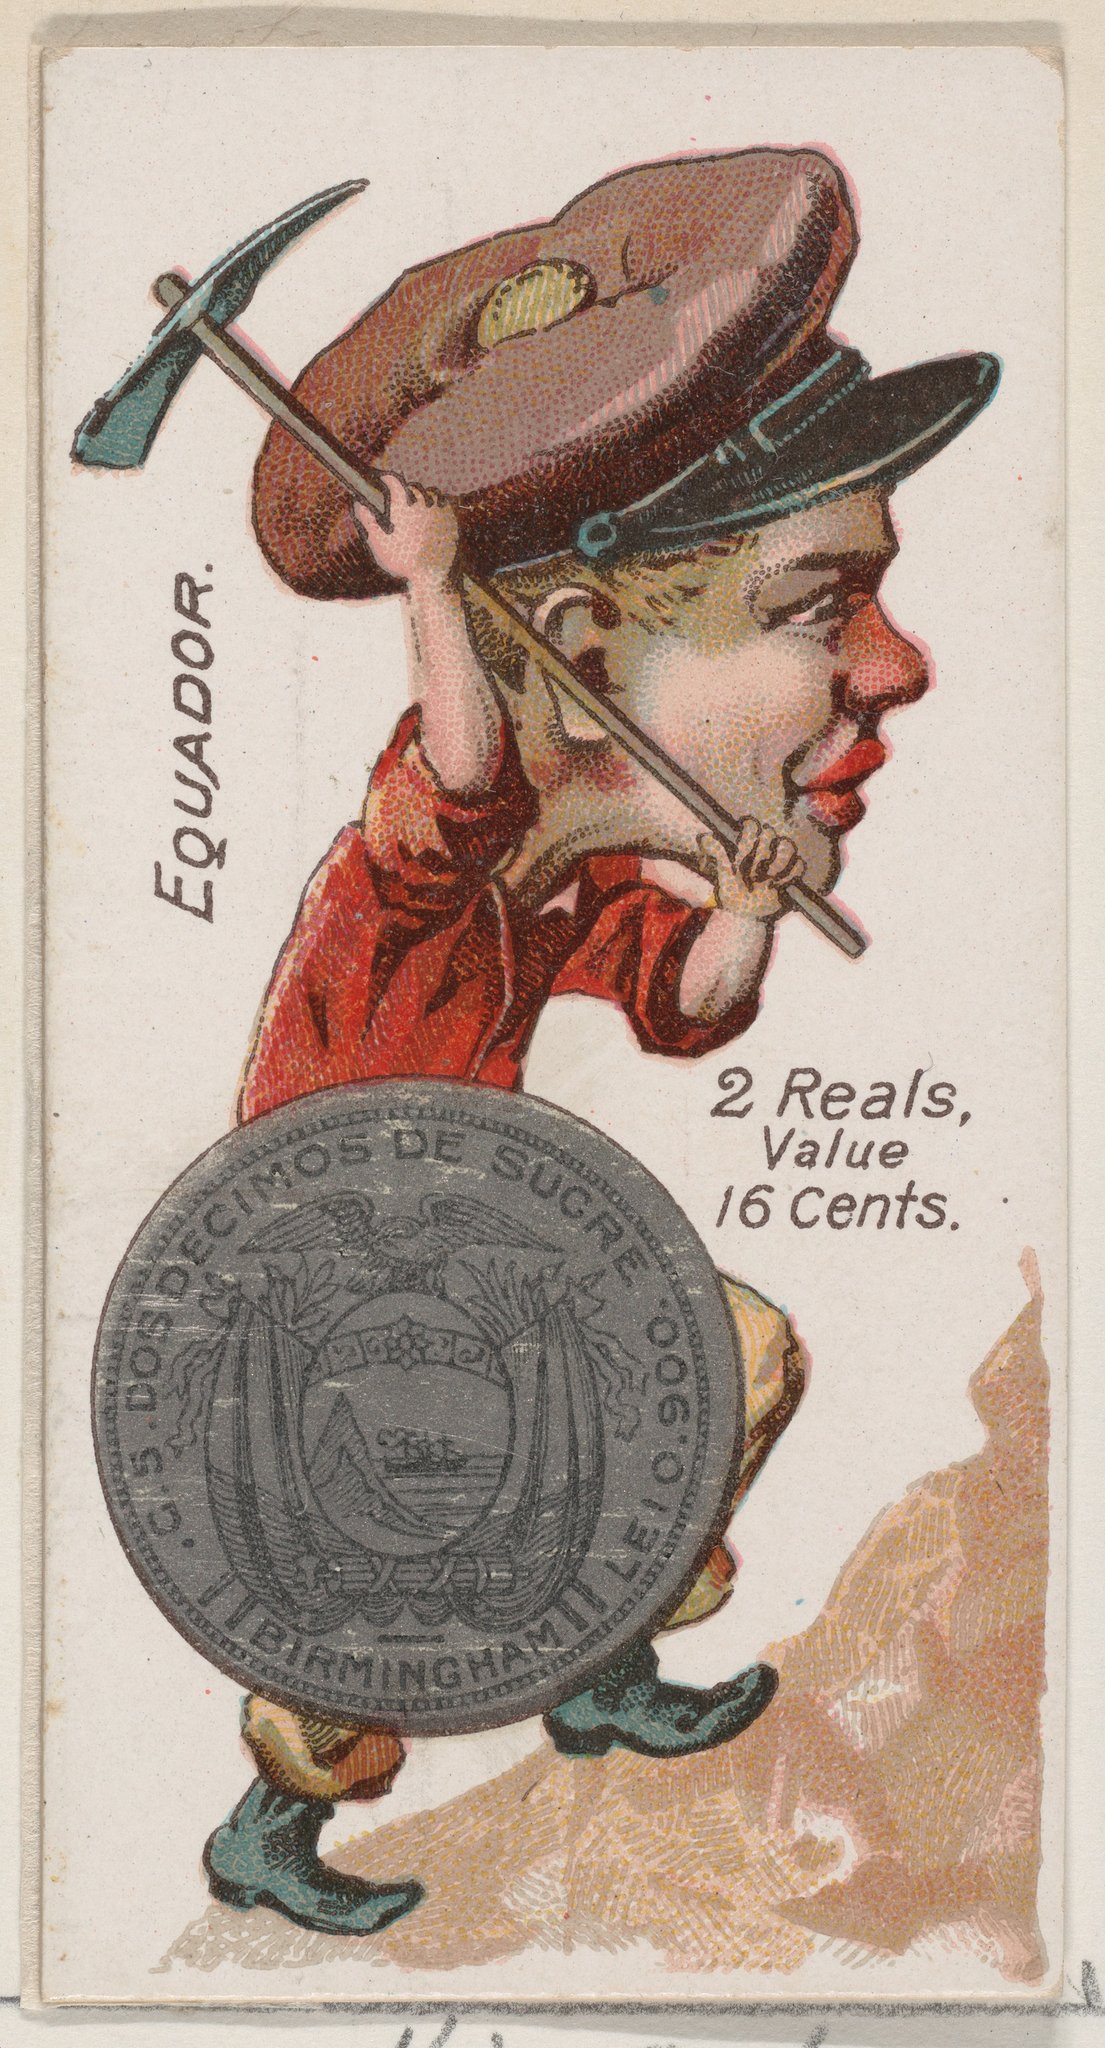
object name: print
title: Ecuador, 2 Reals, from the series Coins of All Nations (N72, variation 1) for Duke brand cigarettes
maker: w. duke, sons & co.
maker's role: publisher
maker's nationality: american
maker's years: 1870-1920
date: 1889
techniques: color lithograph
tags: men,coins